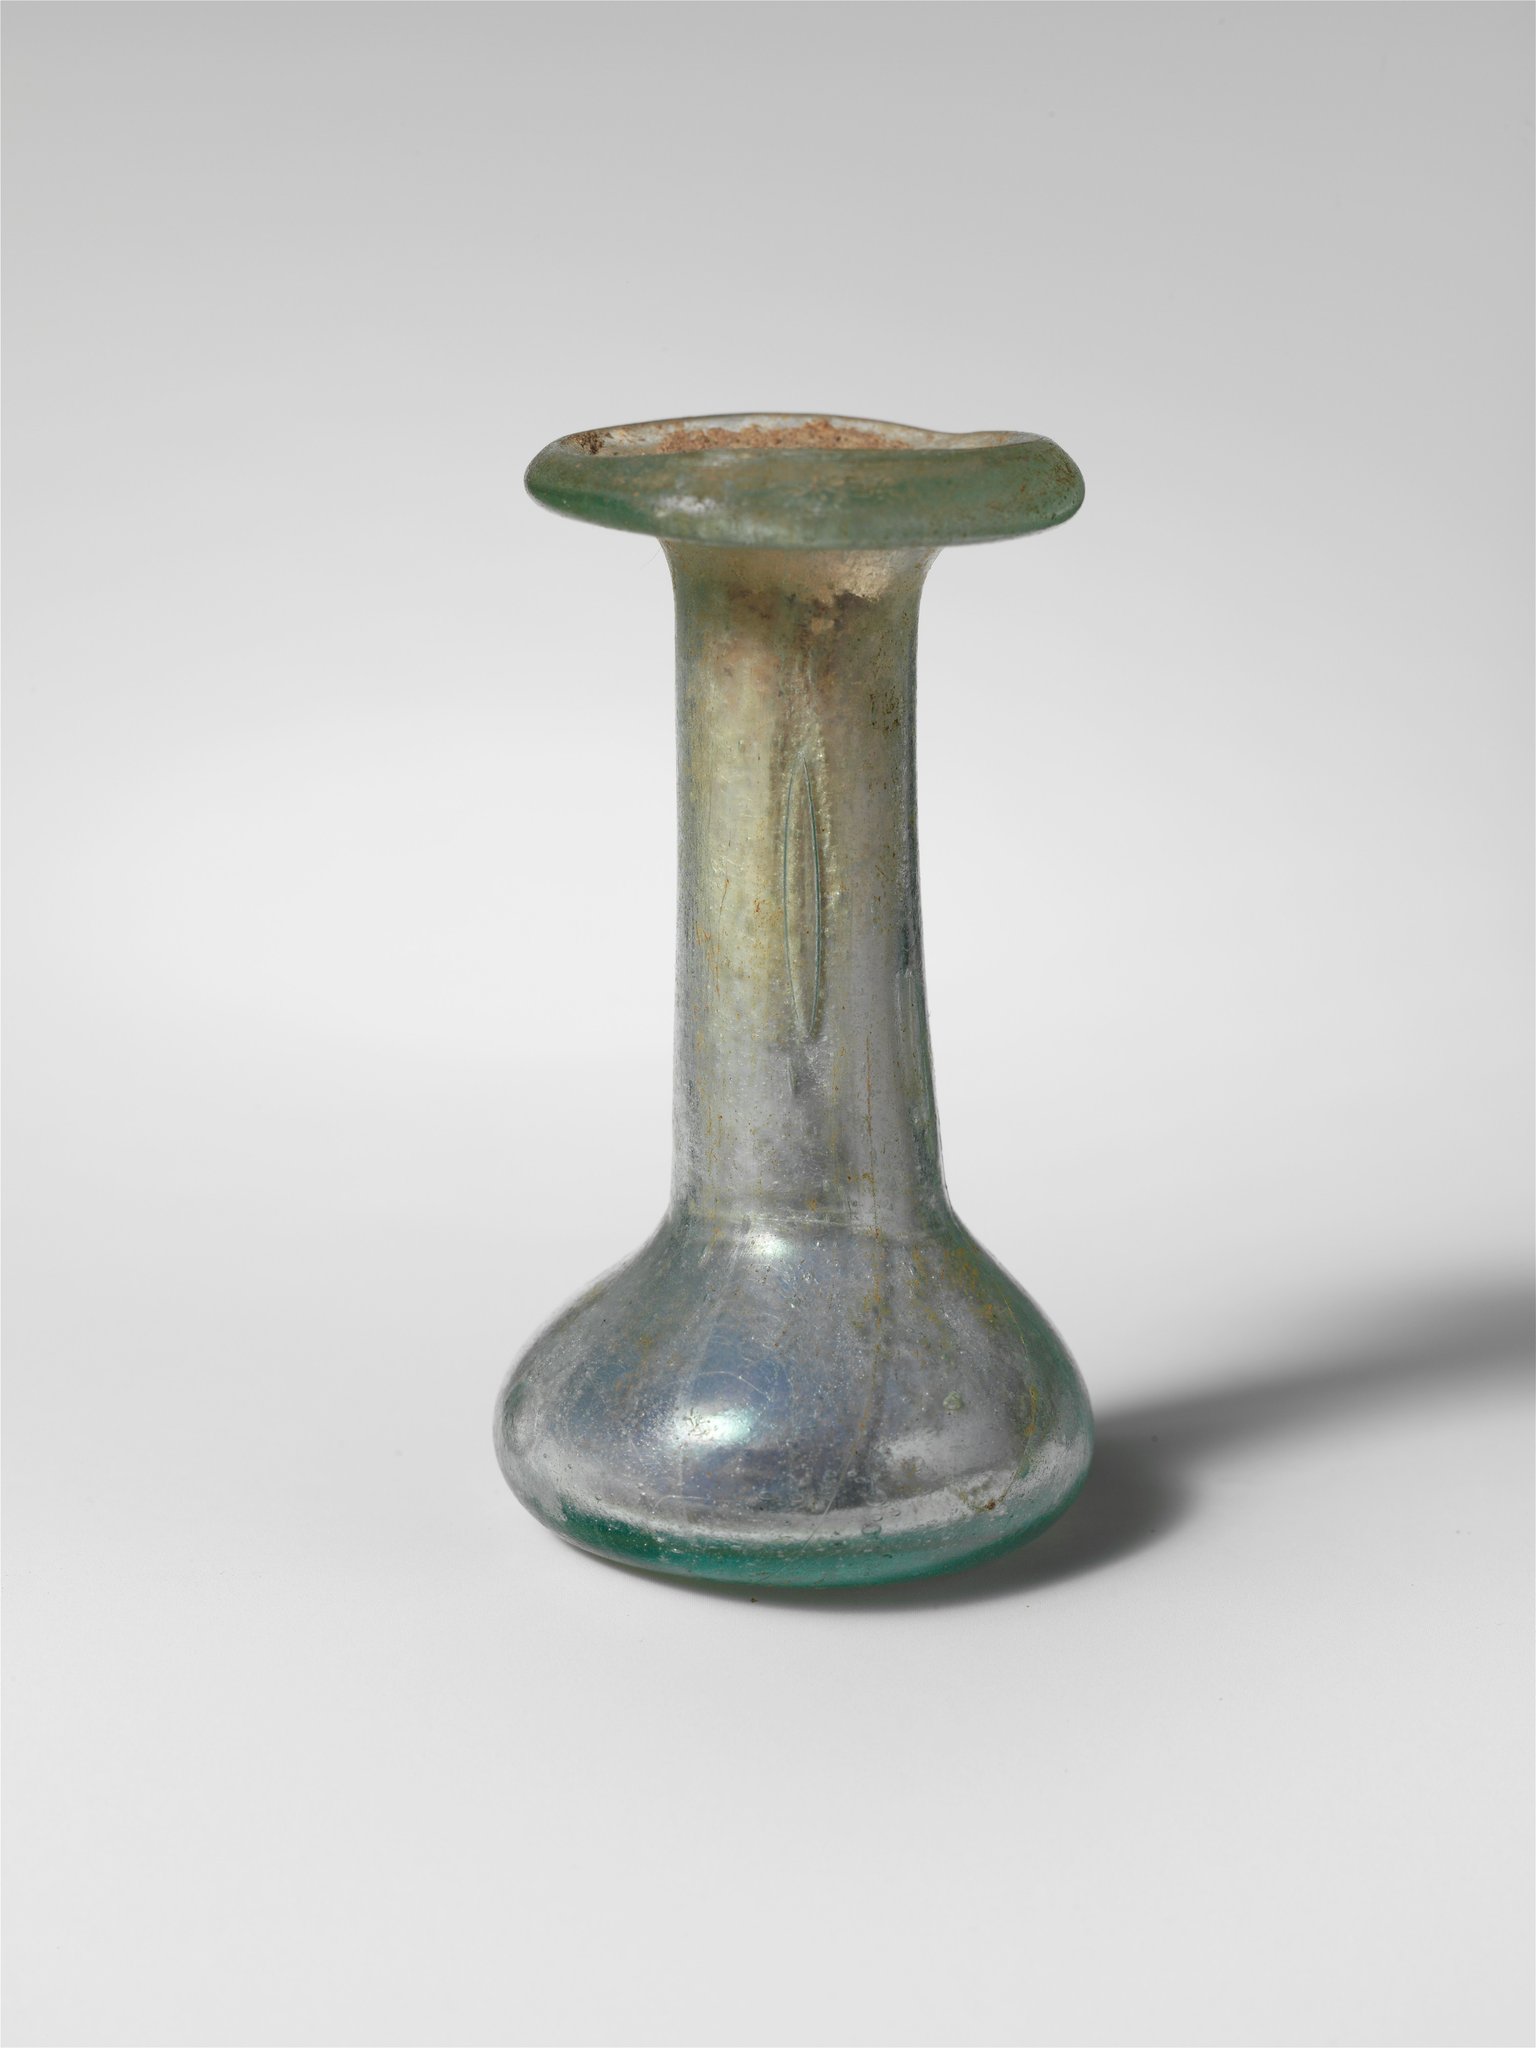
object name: perfume bottle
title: Glass perfume bottle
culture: roman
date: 67-300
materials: glass